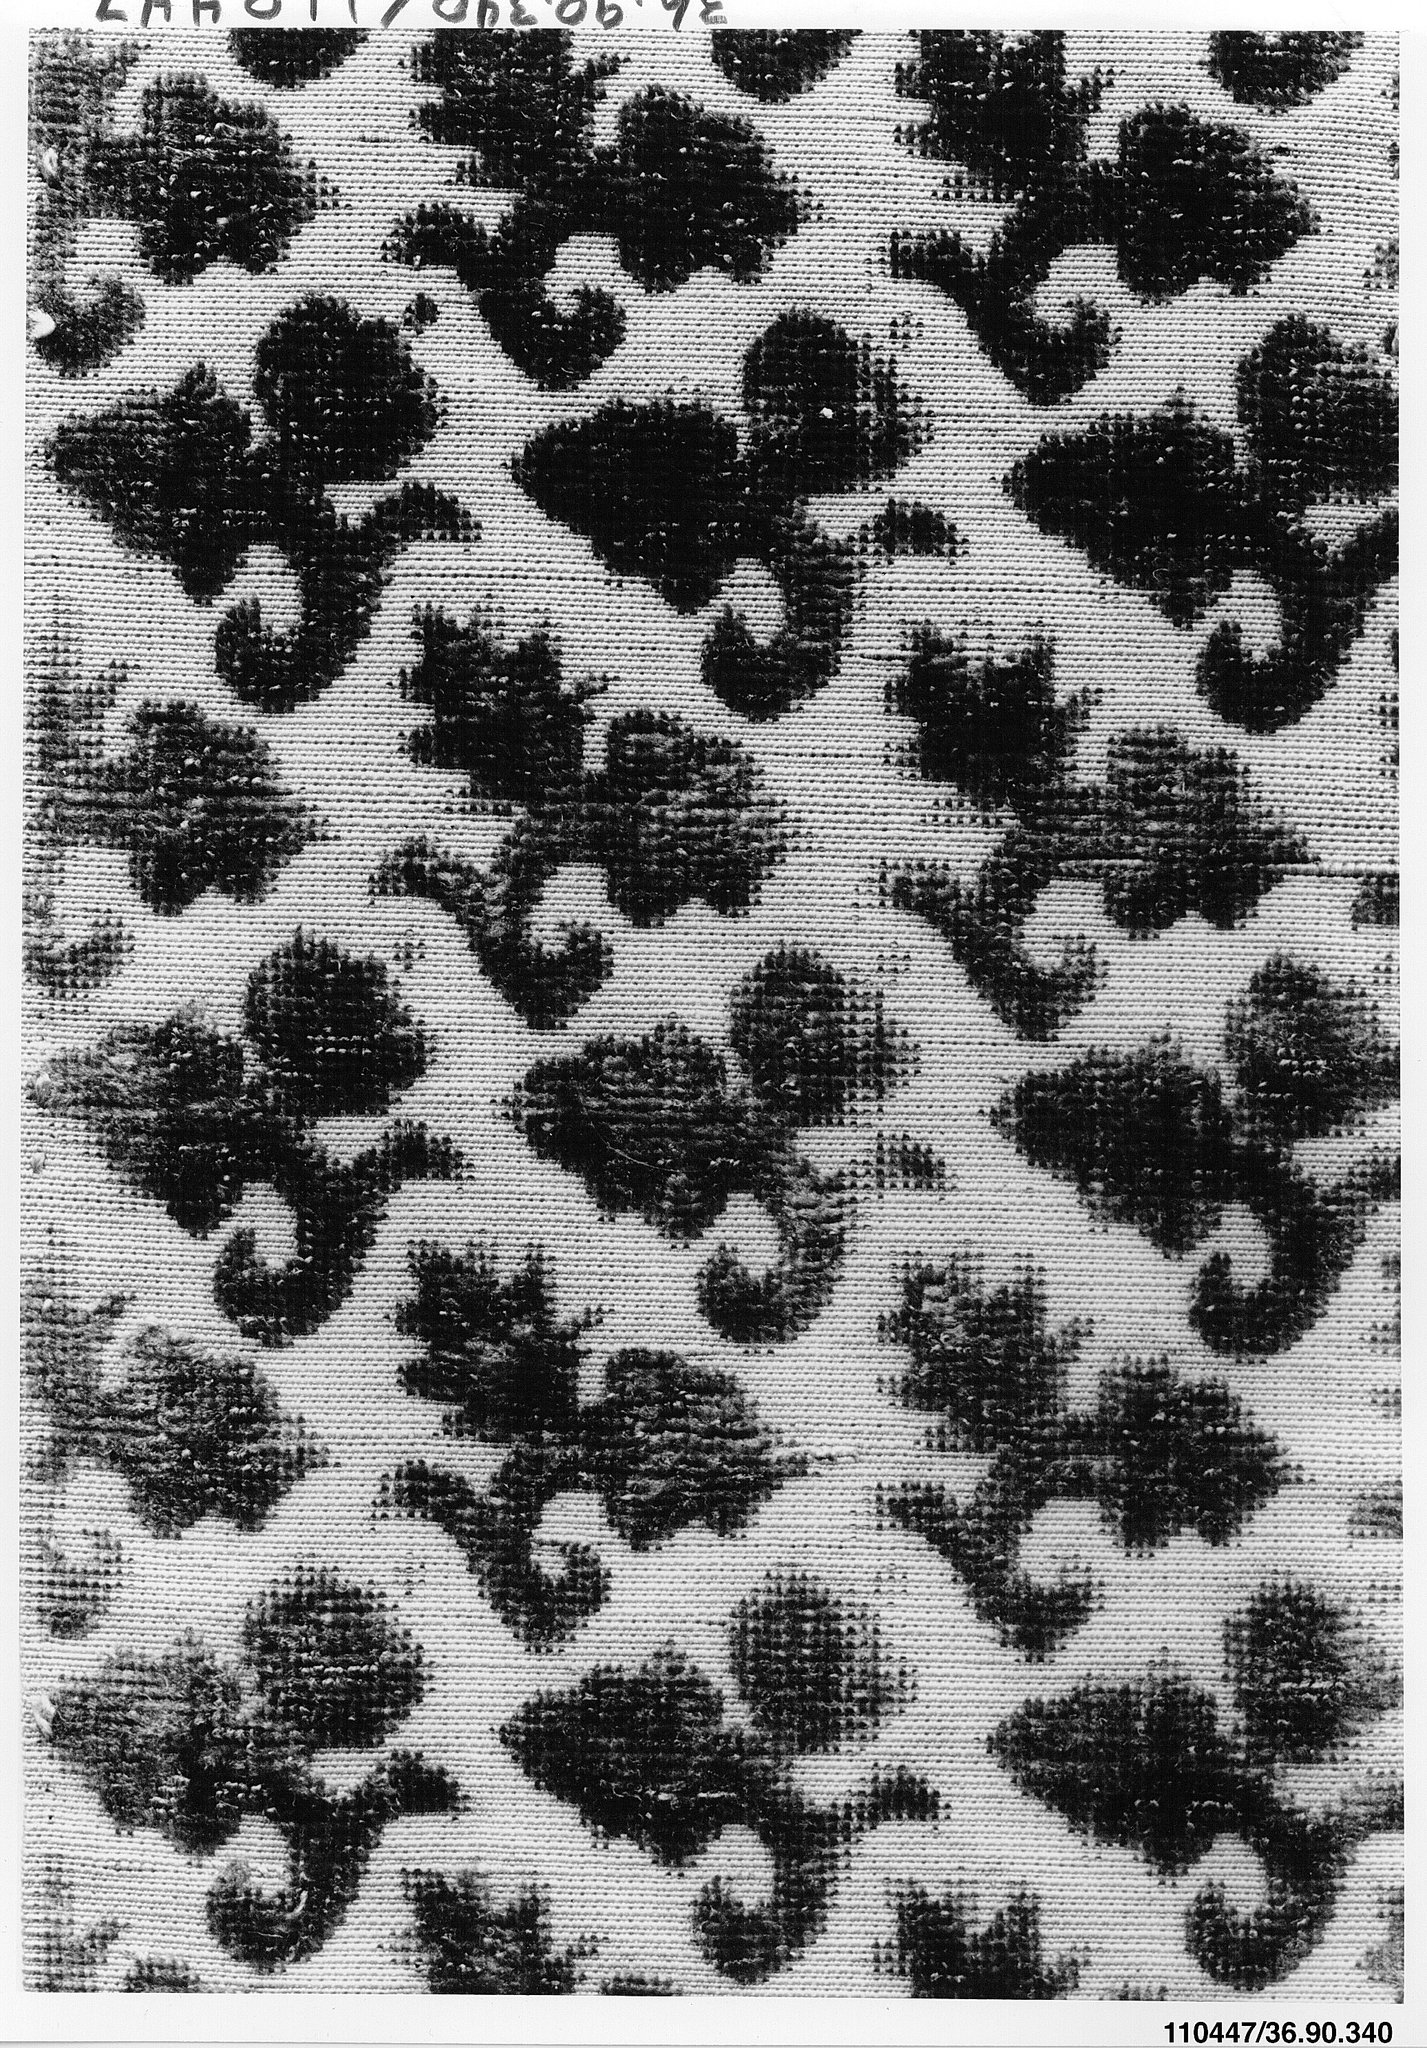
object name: piece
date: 1501-1700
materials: silk